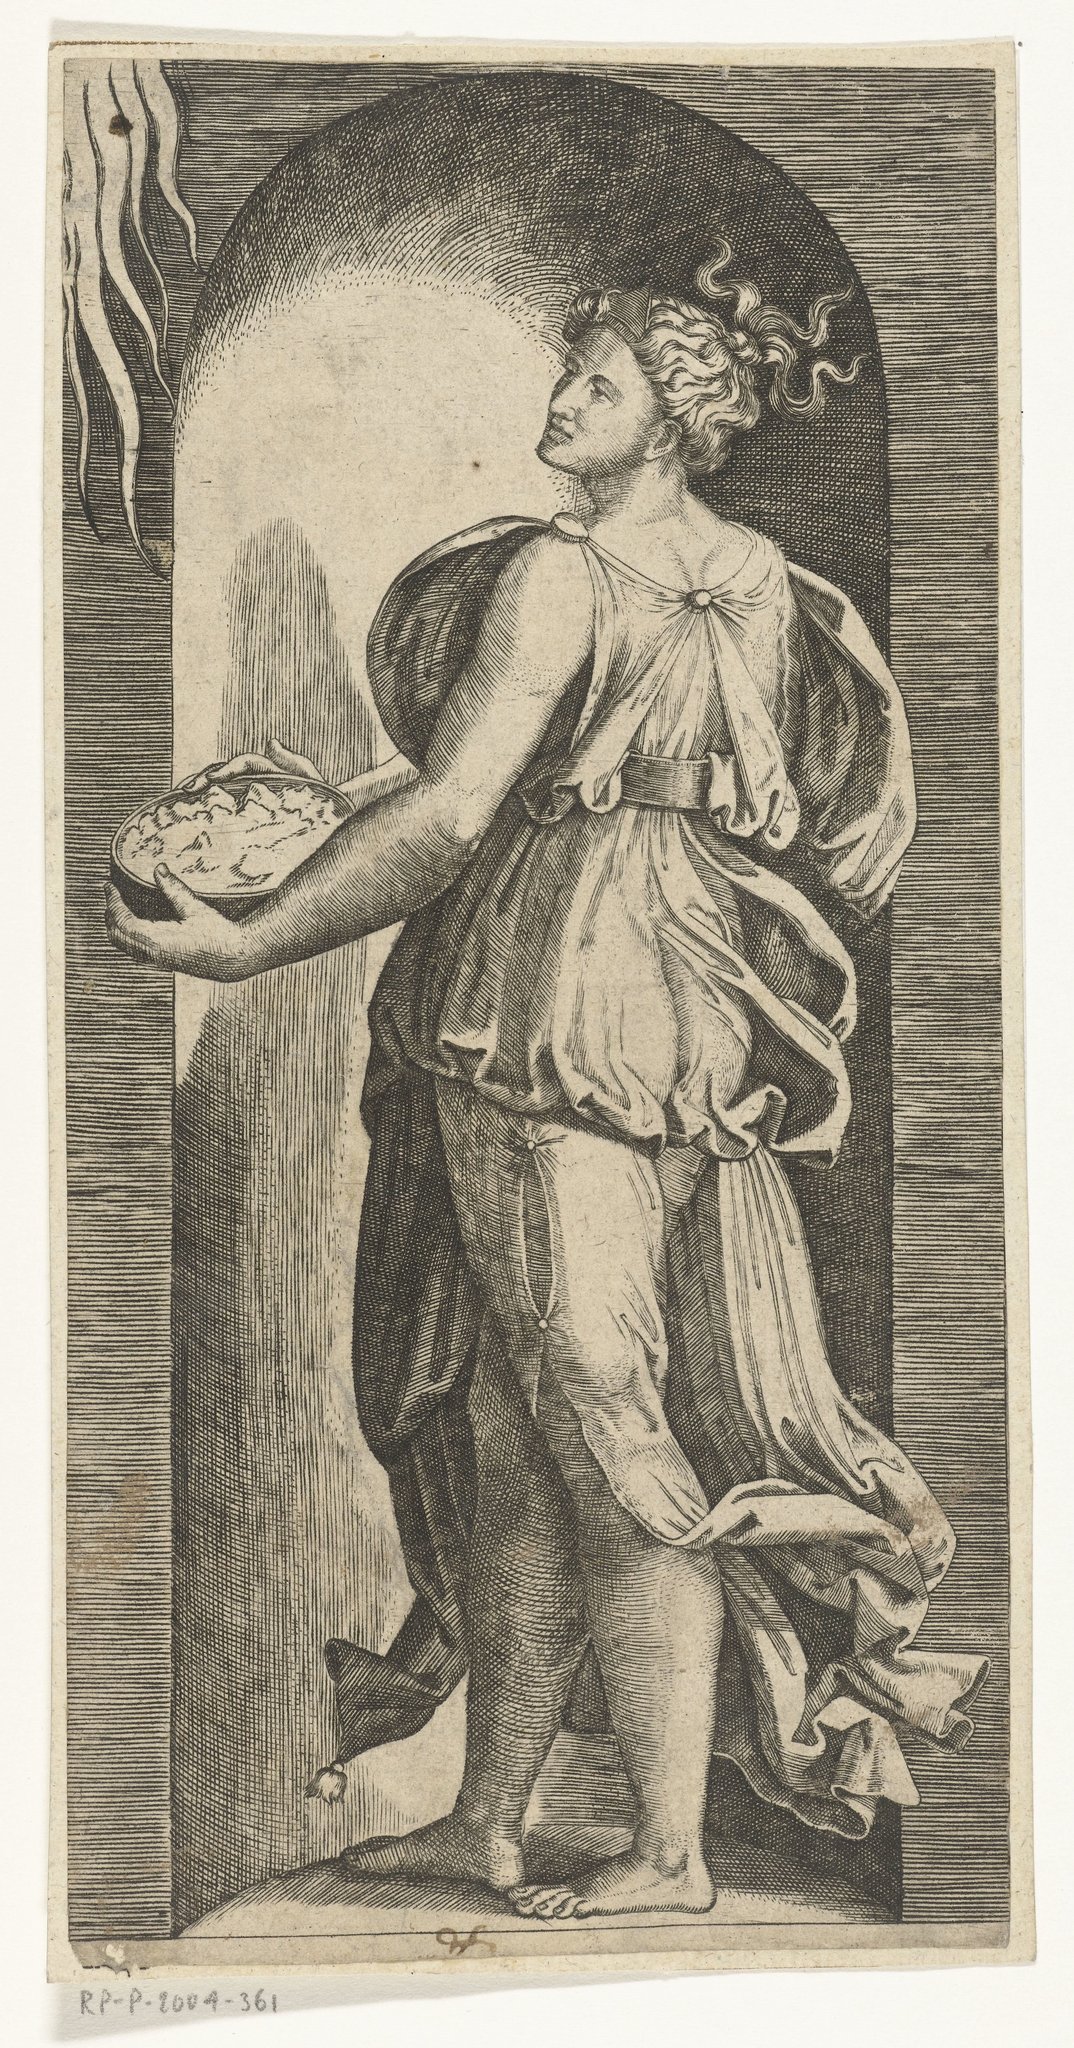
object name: print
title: Zeven deugden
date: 1510-1575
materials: paper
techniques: engraving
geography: italy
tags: hope, 'spes'; 'speranza divina e certa' (ripa) ~ one of the three theological virtues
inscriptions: collector's mark: Lugt 2760, collector's mark: Lugt 2228a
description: Kopie in spiegelbeeld naar prent van Marcantonio Raimondi. Raimondi baseerde zich mogelijk op een ontwerp van Raphael. Prent uit een serie van zeven prenten met deugden.